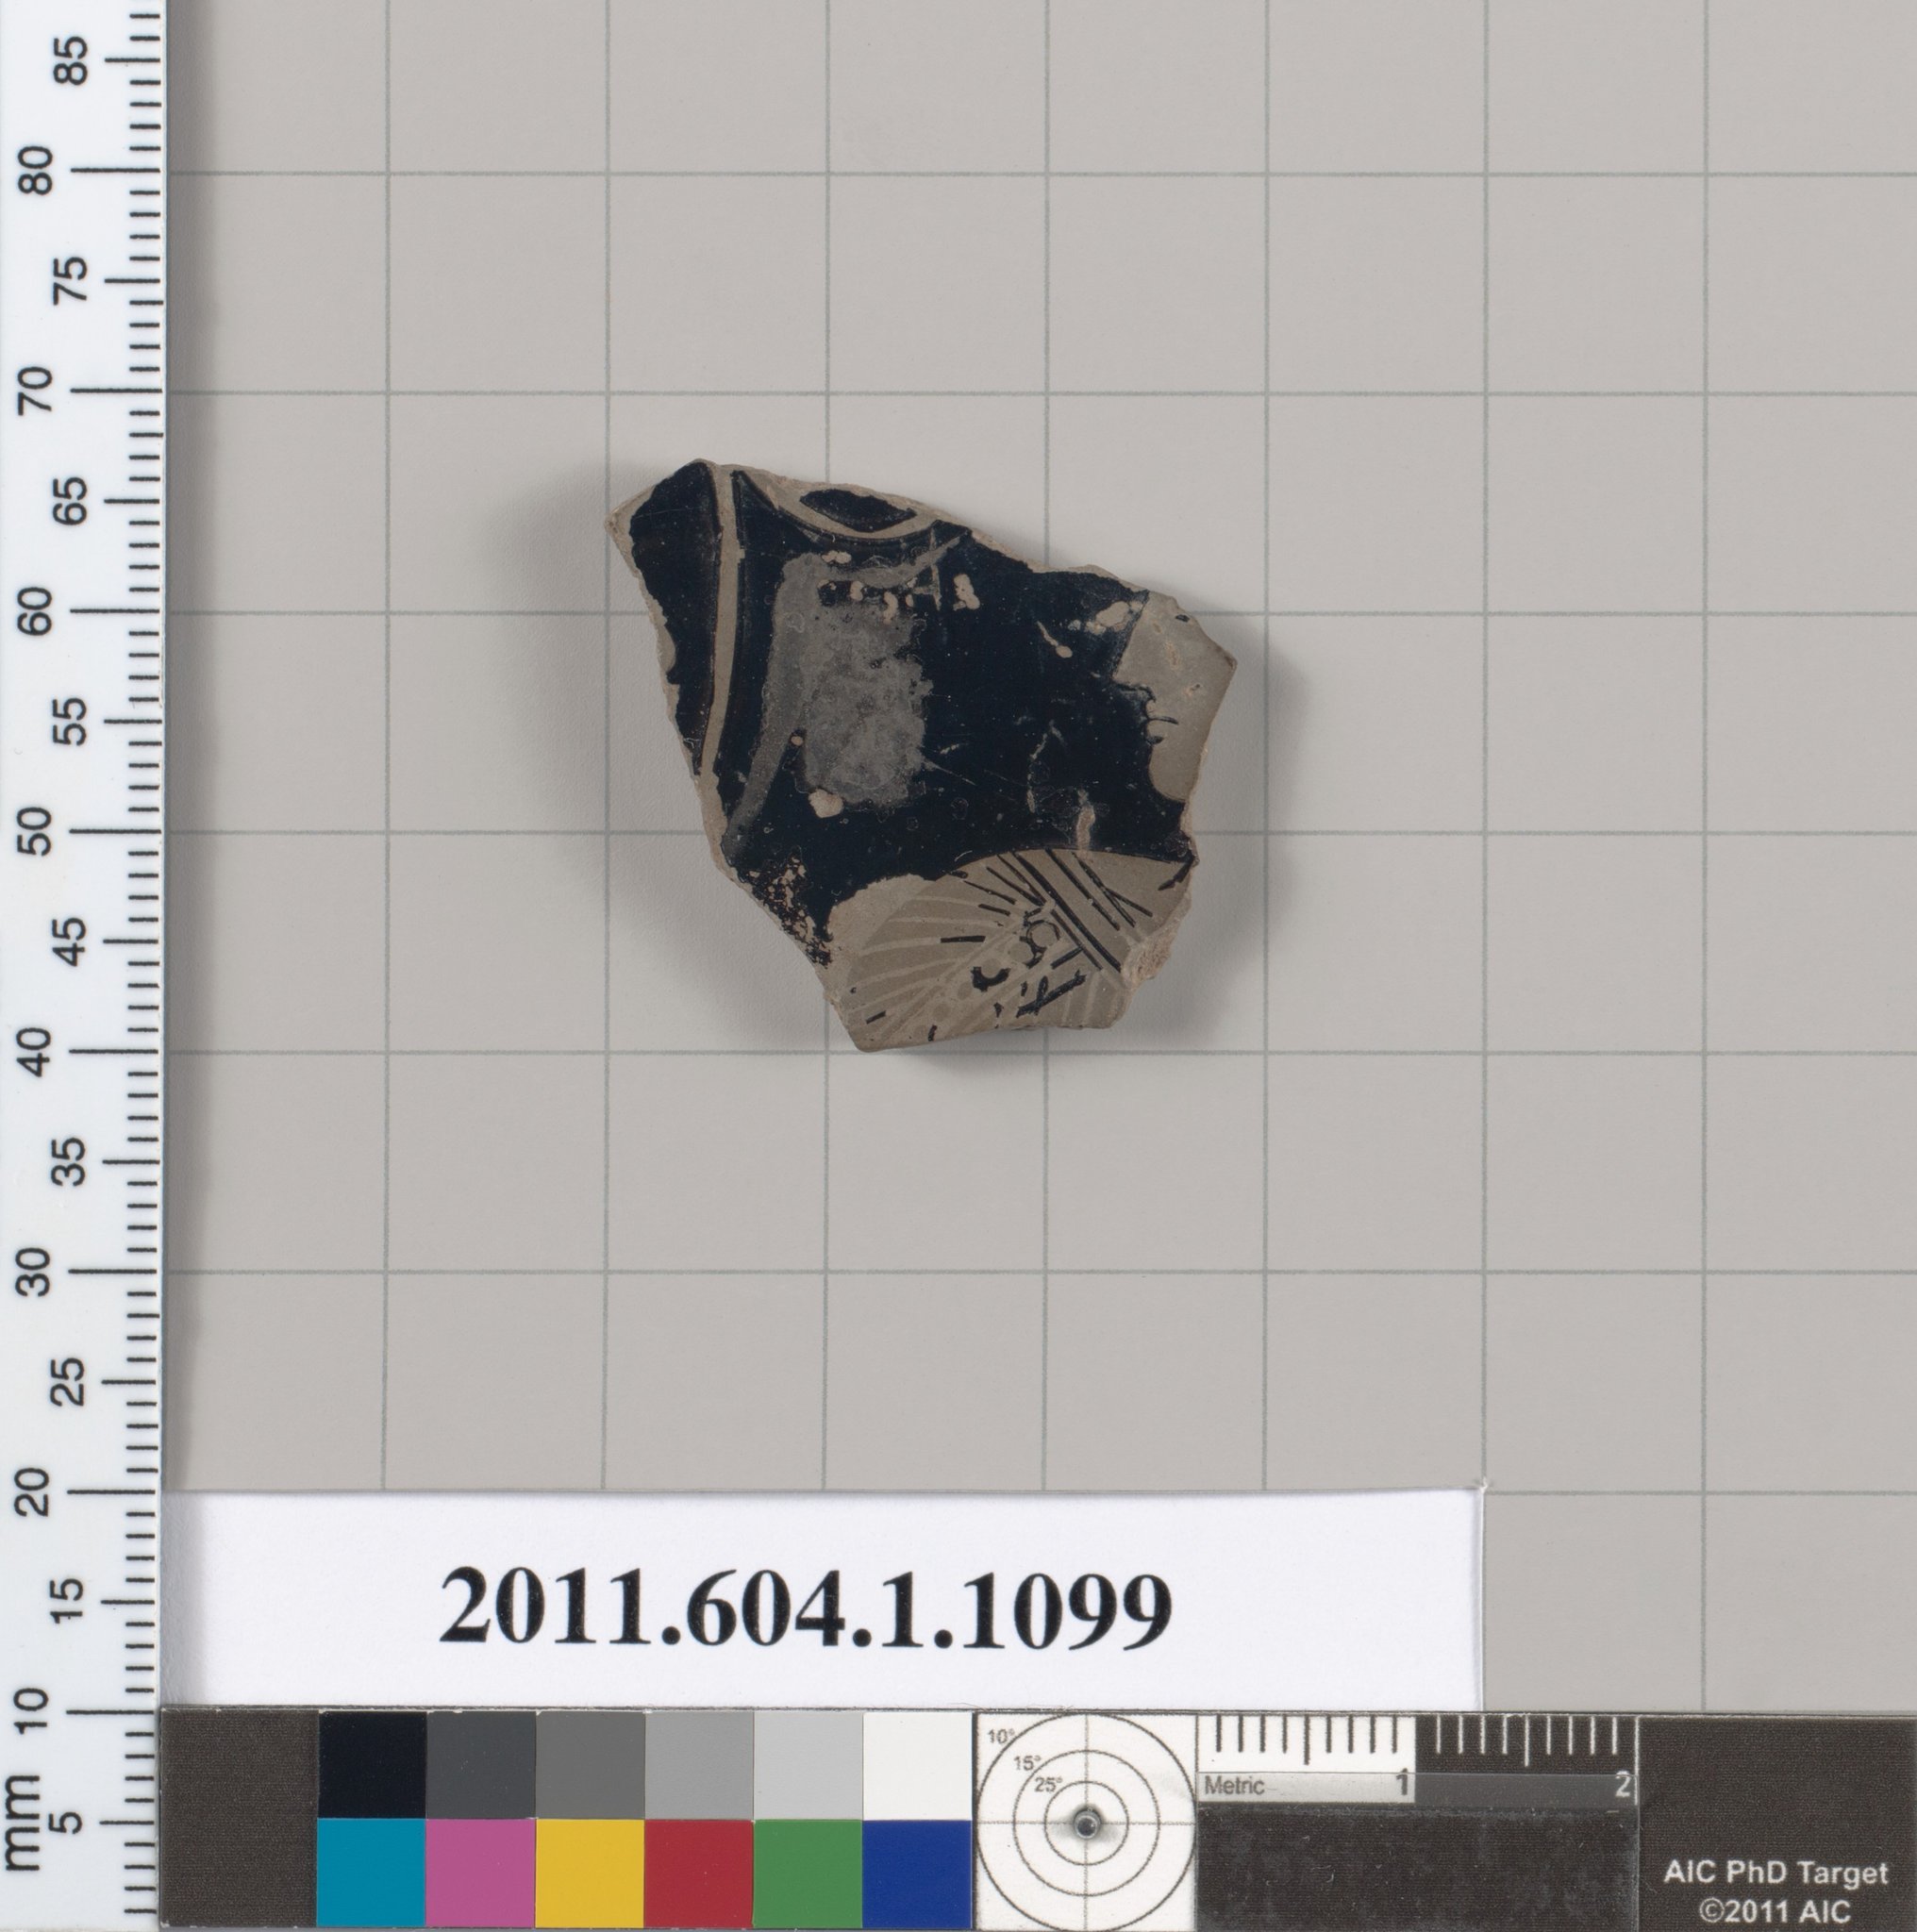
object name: kylix fragment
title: Terracotta fragment of a kylix (drinking cup)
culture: greek, attic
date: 475-451 BCE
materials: terracotta